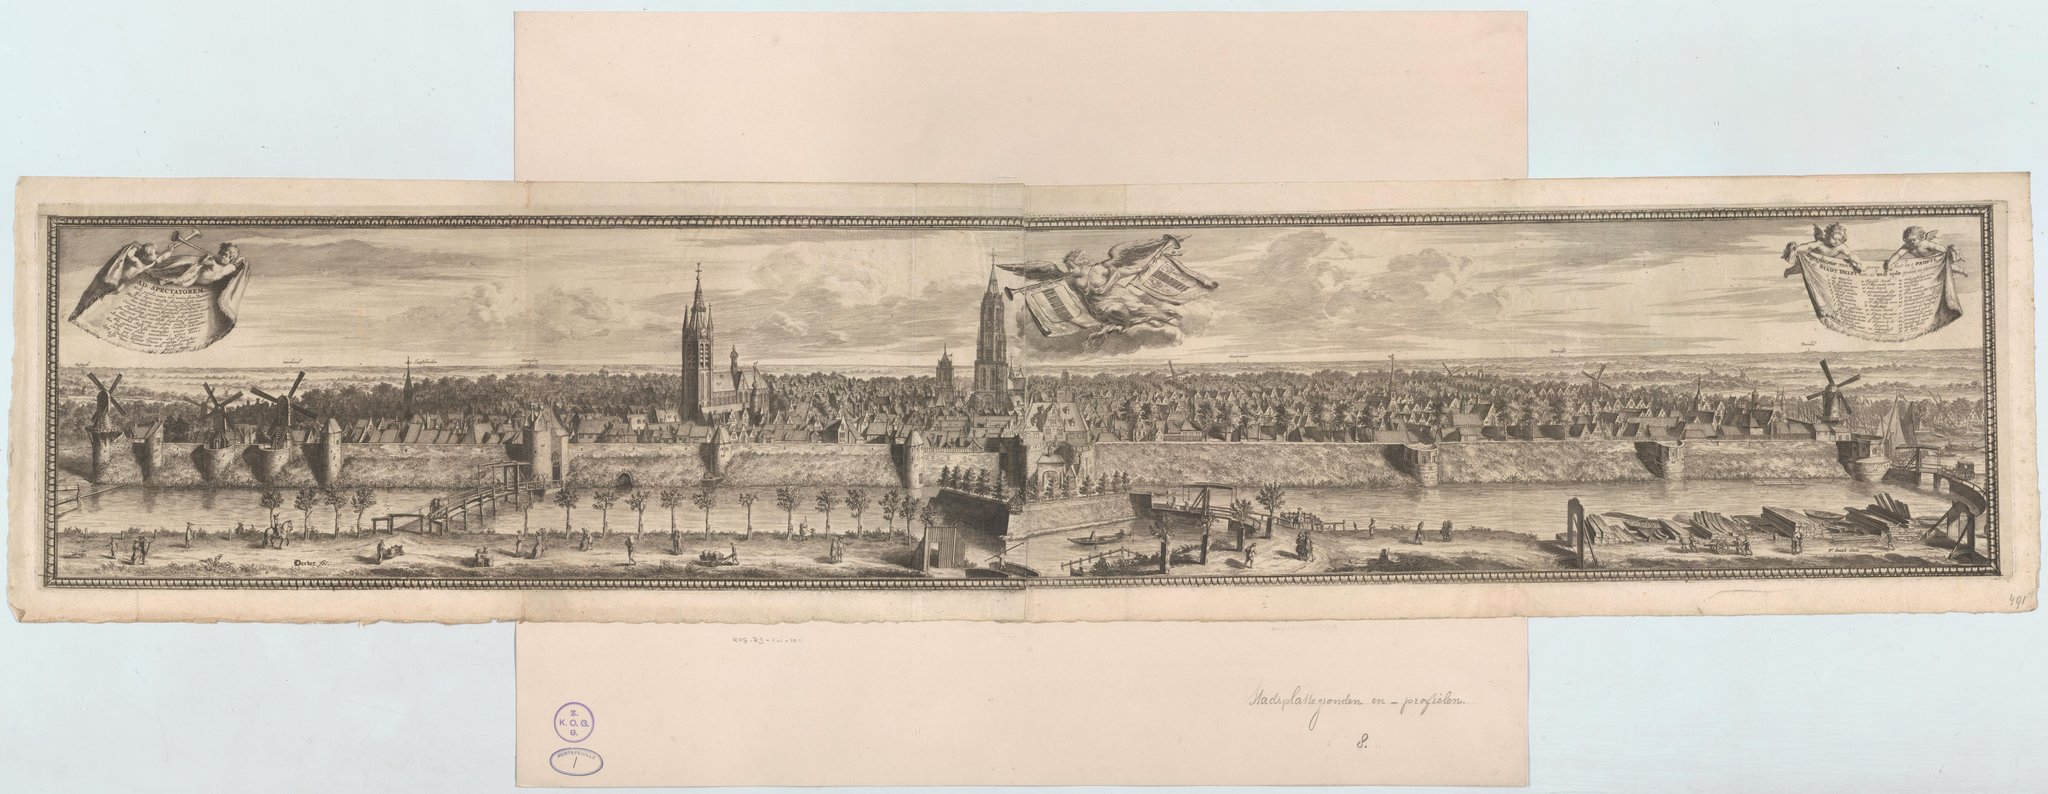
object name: print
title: Profiel van de stad Delft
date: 1676-1678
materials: paper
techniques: engraving, etching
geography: northern netherlands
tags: fame; 'fama', 'fama buona', 'fama chiara' (ripa), prospect of city, town panorama, silhouette of city, delft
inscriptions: collector's mark, collector's mark: Lugt 1641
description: Deze prent is onderdeel van de rand van de zogenaamde Kaart Figuratief (Caerte figuratyff / Kaerte figuratyf) van Delft, een wandkaart van Delft. Deze kaart bestaat uit een plattegrond van Delft met daaromheen een rand. De rand bestaat uit een profiel van Delft, een profiel van Delfshaven met daaronder de wapenschilden van de burgemeesters van de stad, 24 kleinere prenten (kaarten, afbeeldingen van gebouwen en graven van bekende personen en een beschrijving van de stad. De eerste druk van deze Kaart Figuratief (1678) werd, in opdracht van het Delftse stadsbestuur, verzorgd door Pieter Smith. Pieter Mortier (I) verzorgde in 1703, tevens in opdracht van het stadsbestuur, een tweede uitgave van de Kaart Figuratief. Voor deze druk bracht graveur Thomas van der Wilt enkele aanpassingen aan op de platen van de plattegrond. De randplaten lijken, op de plaat met de wapens van de burgemeesters na, ongewijzigd te zijn gebleven. De plattegrond is in 1752, waarschijnlijk zonder de randprenten, opnieuw uitgegeven. Een deel van de randprenten, waaronder de huidige prent, is in 1729 opnieuw gebruikt in: Beschryving der stadt Delft, behelzende een zeer naaukeurige en uitvoerige verhandeling van deszelfs eerste oorsprong (…). Delft: Reinier Boitet, 1729. Op twee na (die van de Nieuwe en Oude Kerk) paste Boitet de platen aan, waardoor van deze prenten een tweede staat ontstond. Of de huidige prent is gebruikt als onderdeel van de rand van de Kaart Figuratief uit 1678 of 1703 is niet na te gaan.